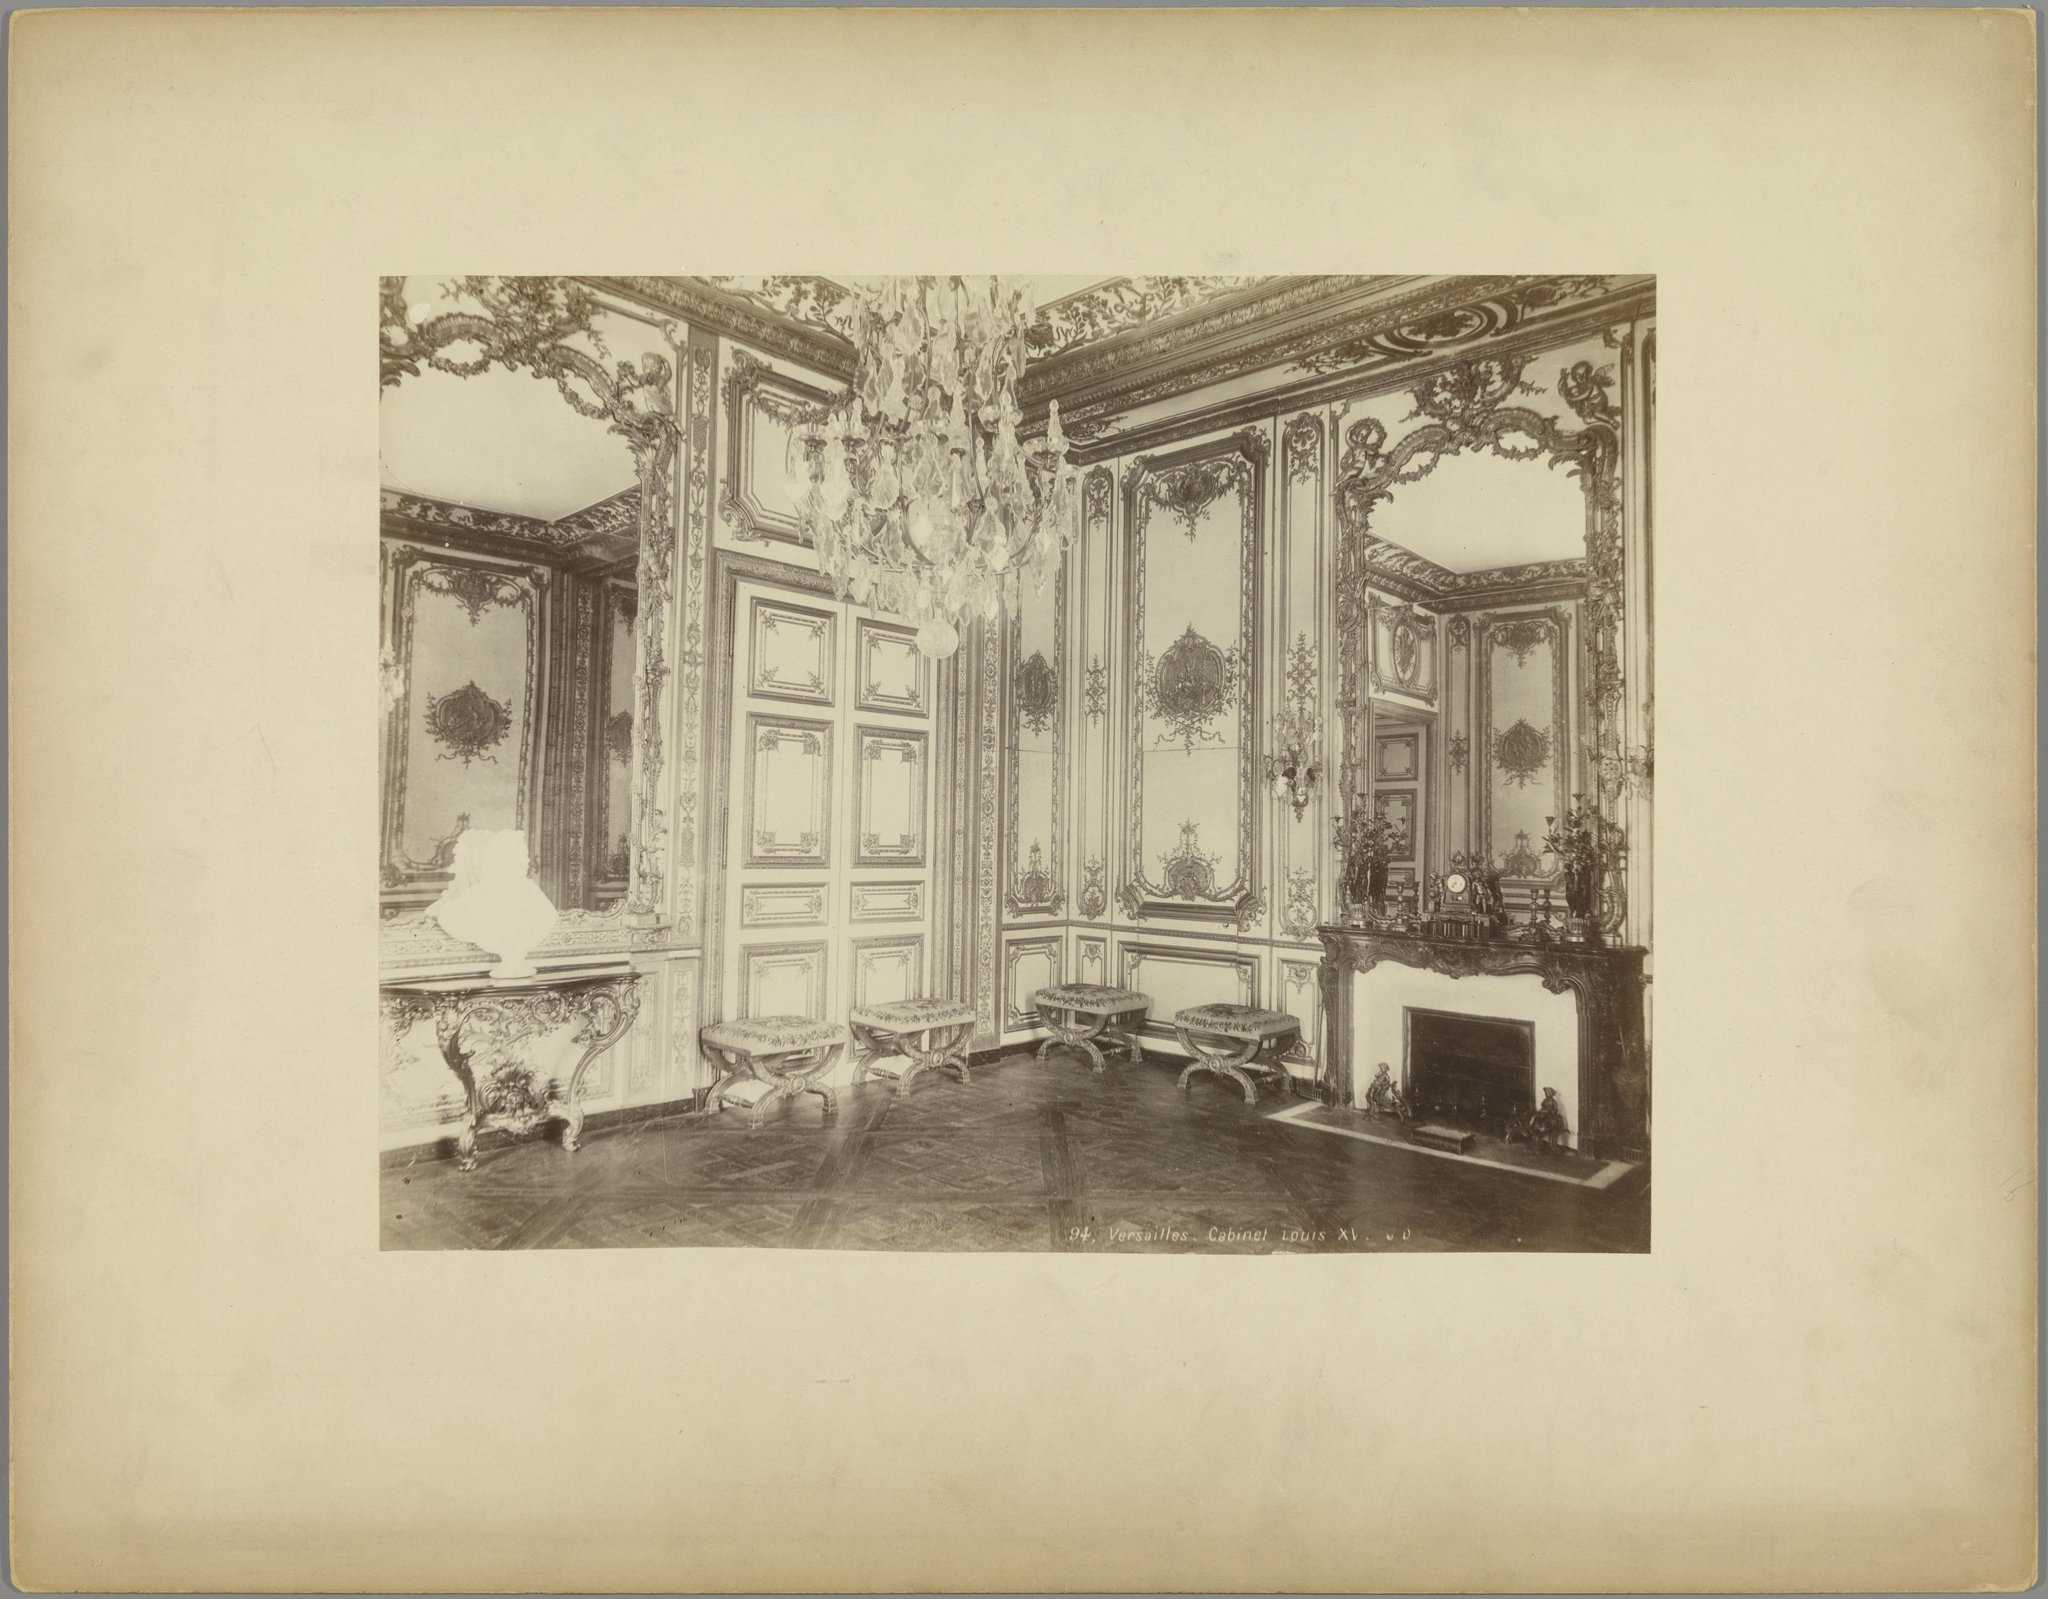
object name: photograph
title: Versailles, Cabinet Louis XV. [(...)]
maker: Anonymous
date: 1875-1900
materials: cardboard, photographic support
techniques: albumen print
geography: versailles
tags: mirror, chandelier, candelabrum, palace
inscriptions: collector's mark: Lugt 3937, number: ‘94.’